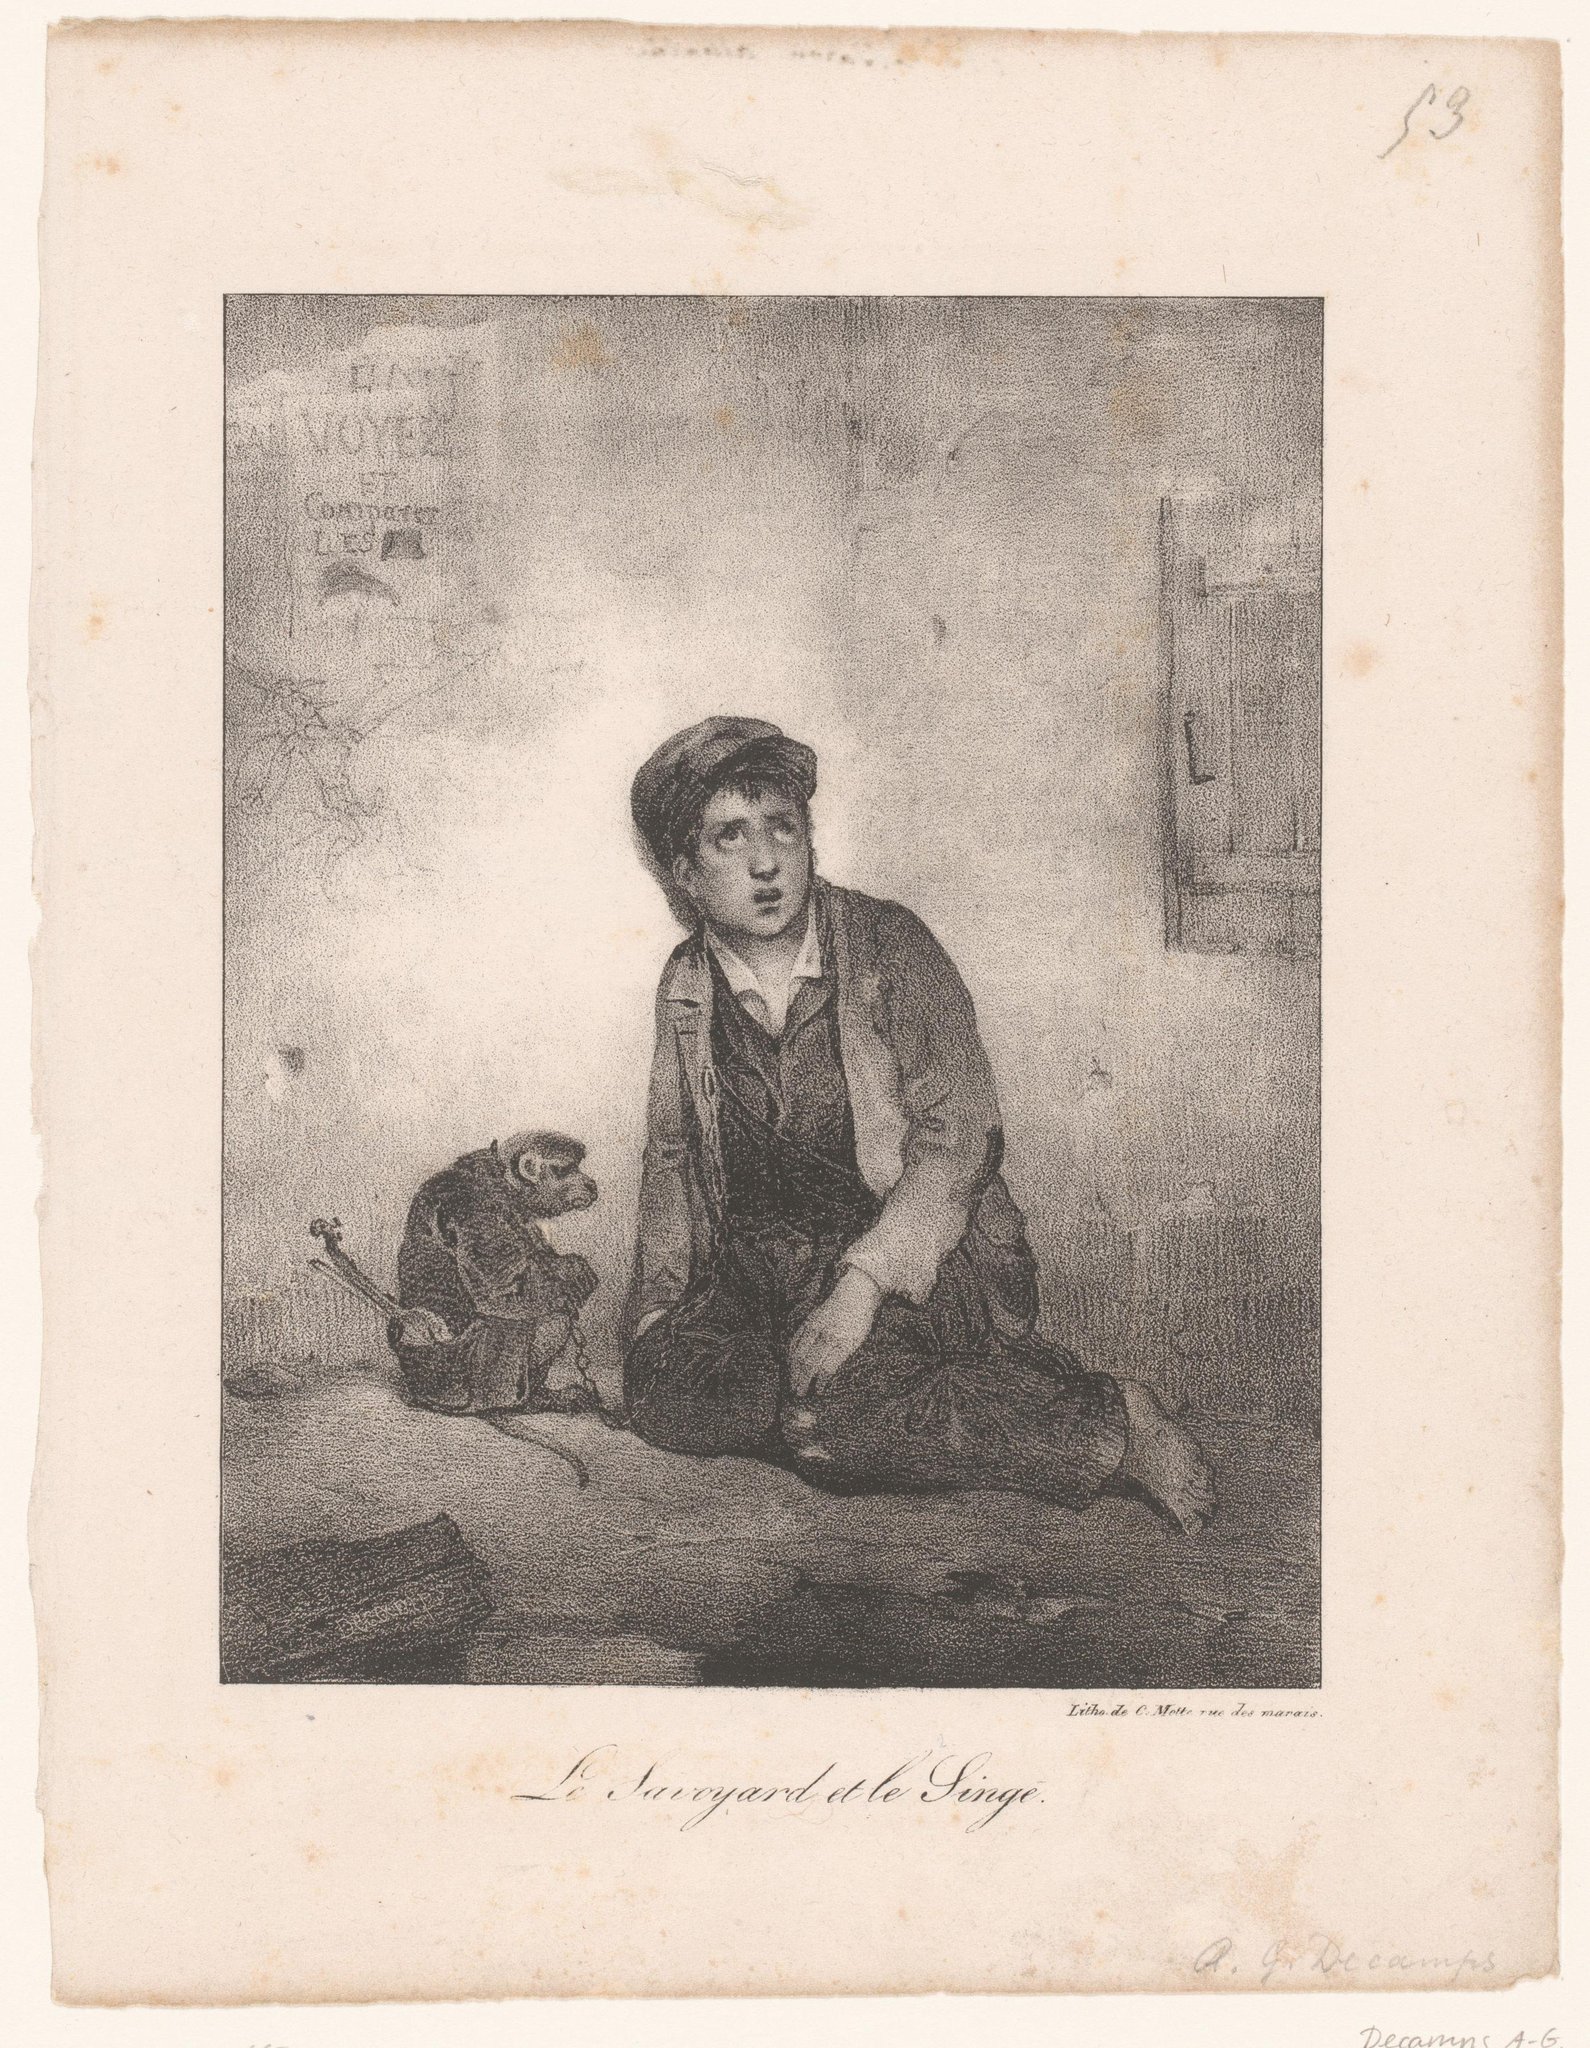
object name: print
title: Straatjongen met aap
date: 1823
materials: paper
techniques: lithograph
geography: paris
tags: earning money with monkey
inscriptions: annotation: ‘Mr le Baron athalin’, collector's mark: Lugt 2228a